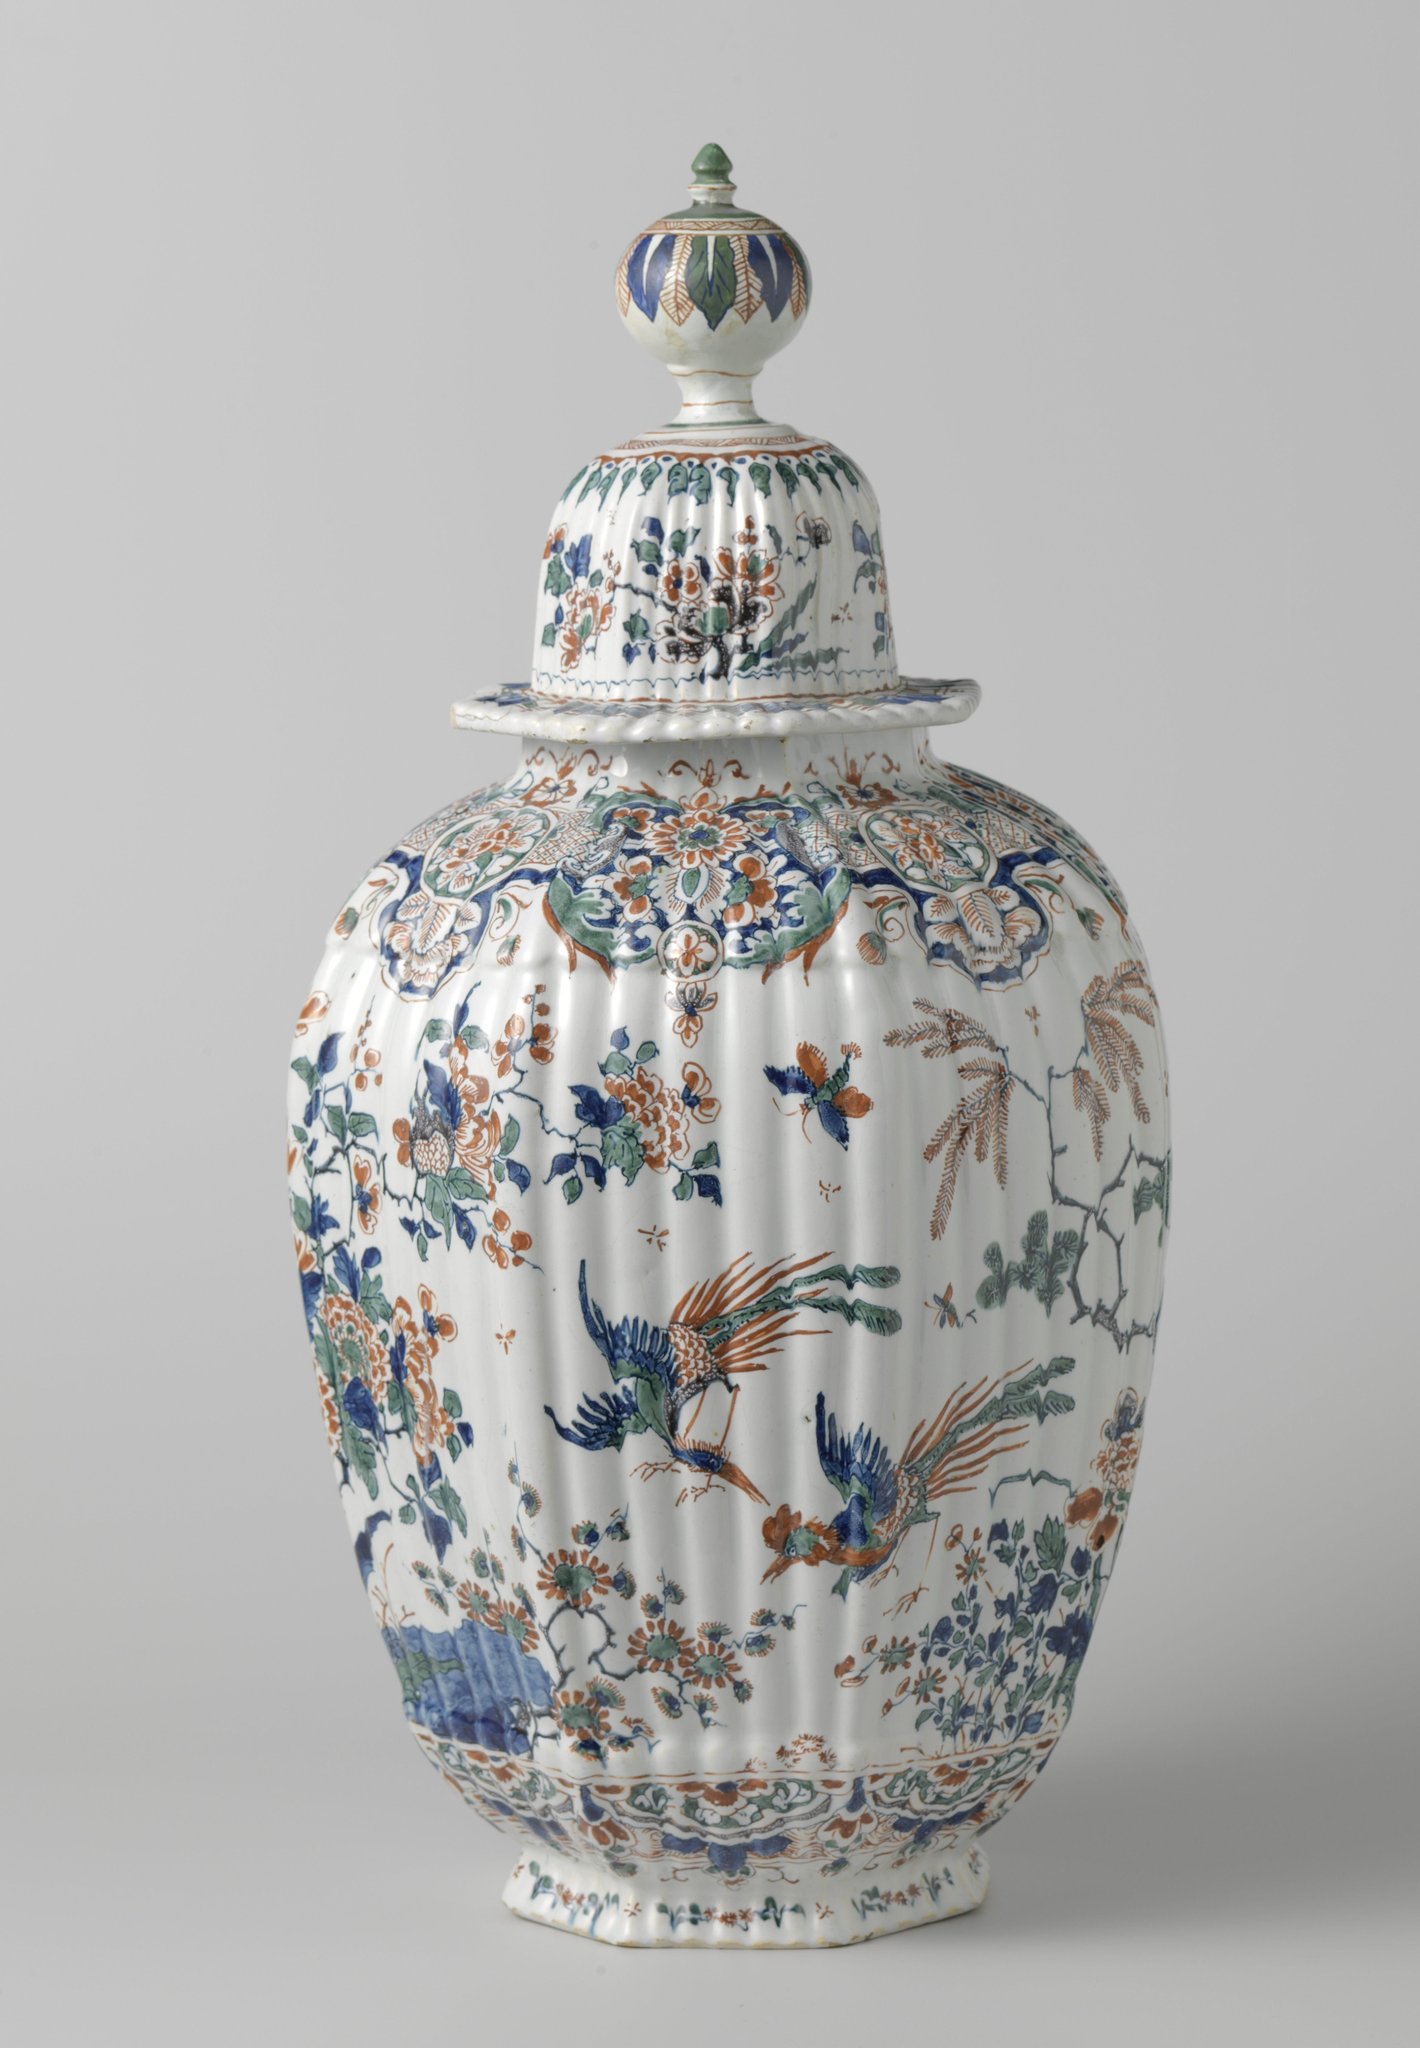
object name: vase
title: Achtkantige geribde vaas met deksel van veelkleurig beschilderde faïence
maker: lambertus van eenhoorn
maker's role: plateelbakker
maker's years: 1651-1721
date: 1695-1725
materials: earthenware, glaze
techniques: painted, polychromy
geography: delft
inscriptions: collector's mark: ‘collection J.F. Loudon’, mark: ‘LVE (ineen)/ IVK/ 3/ c’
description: Cabinet set. Faience. Delft, 'De Dobbelde Schenckan', under Louwijs Fictoor, c. 1700. Presented by the heirs of John F. Loudon, 1916.